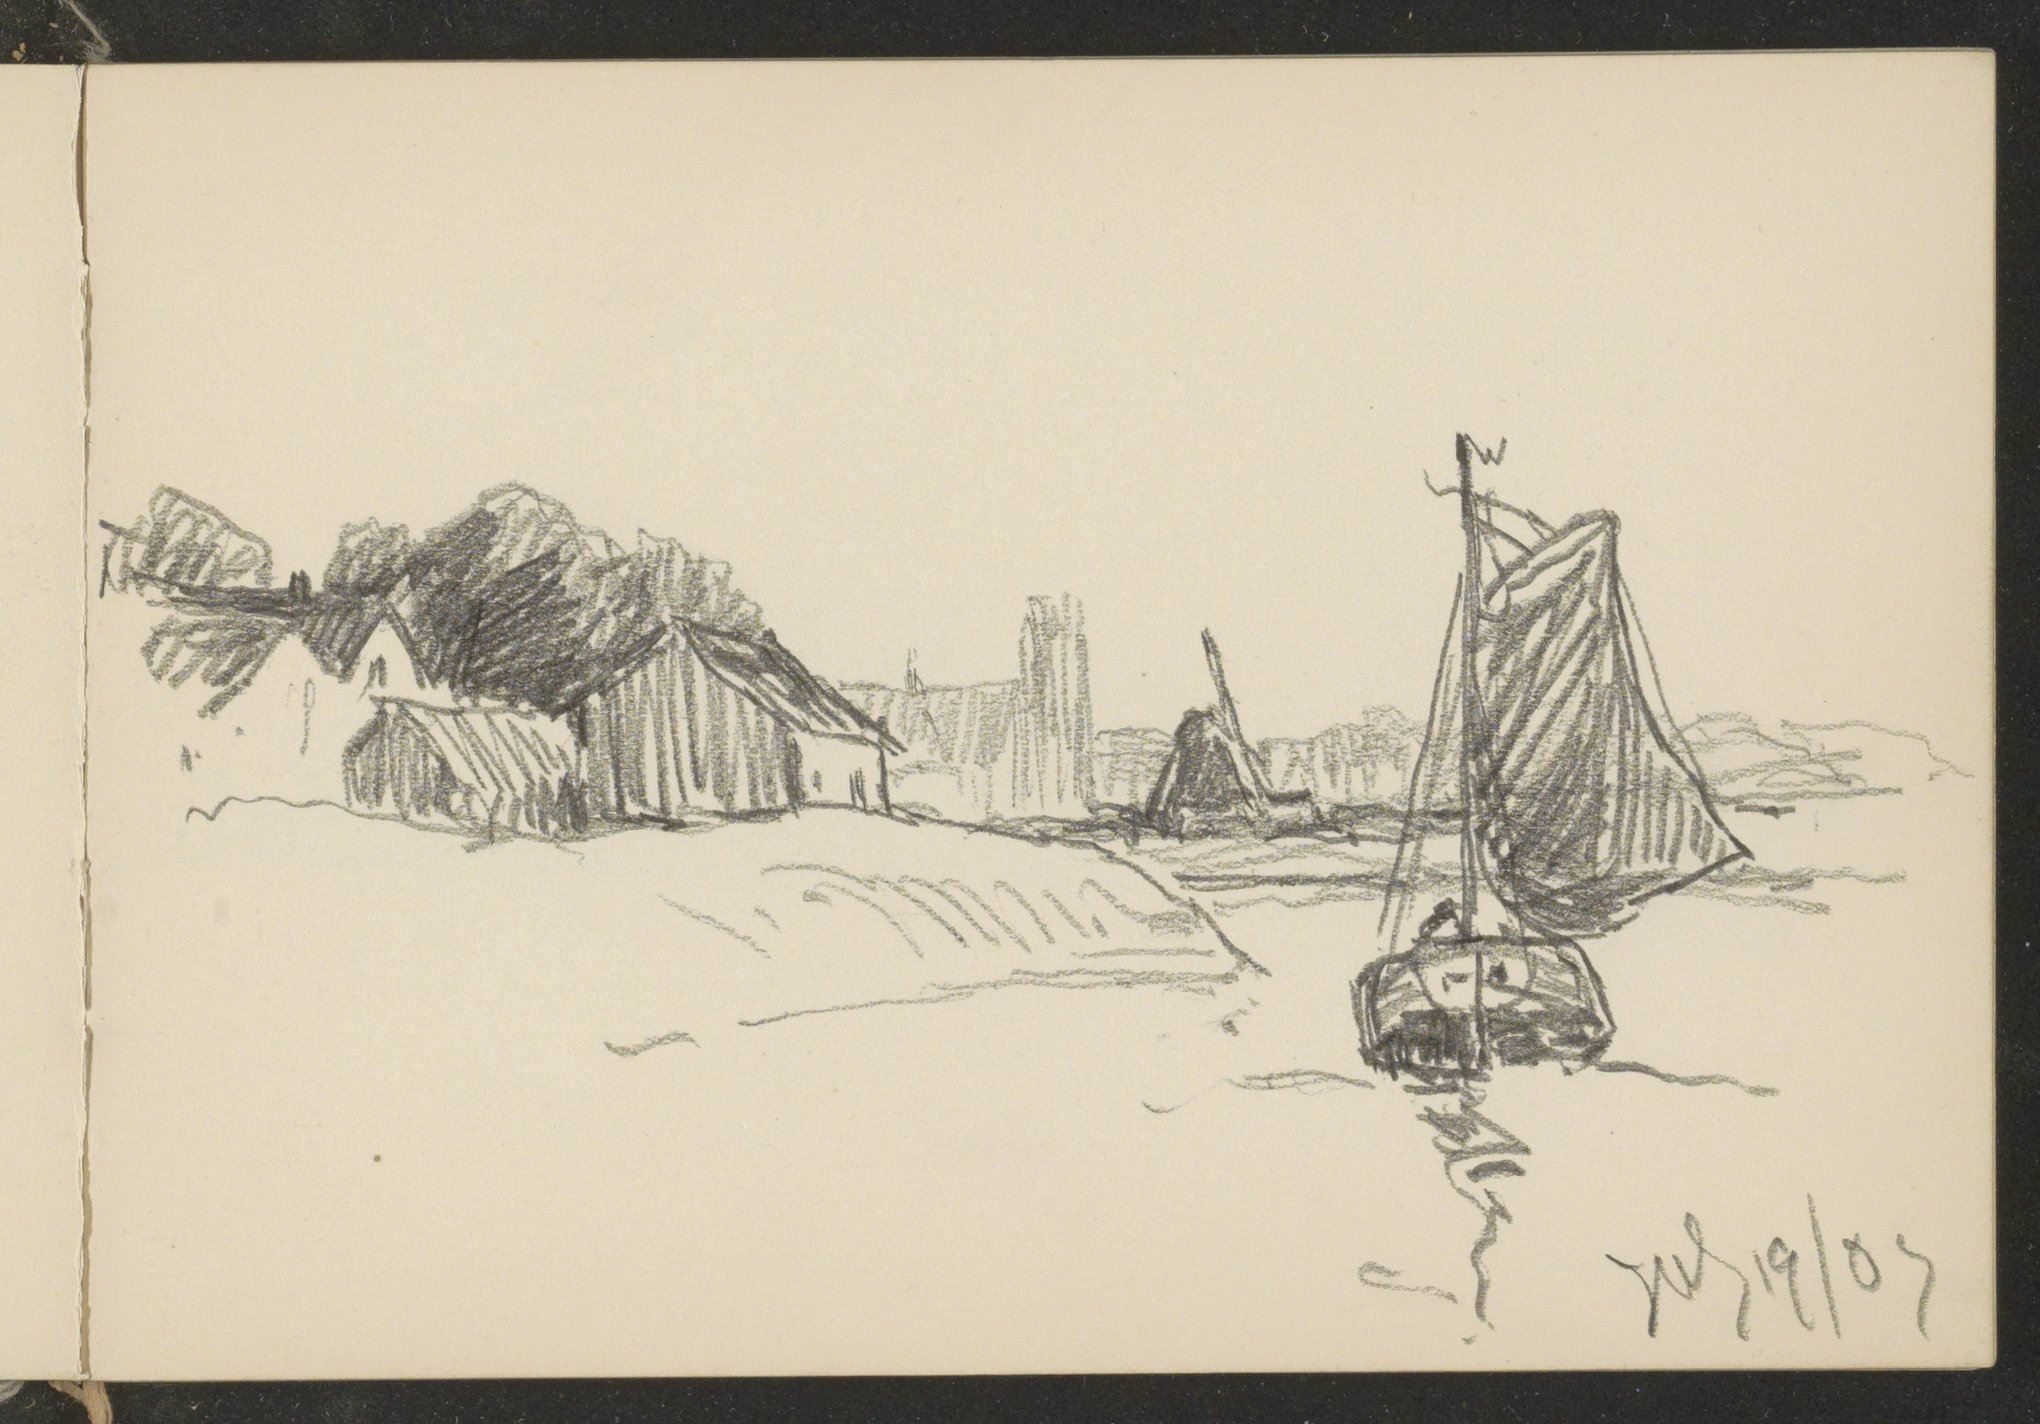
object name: sketchbook leaf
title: Gezicht op Dordrecht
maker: alexander shilling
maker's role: draughtsman, print maker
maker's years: 1859-1937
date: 1907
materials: paper, pencil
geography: dordrecht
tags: city-view, and landscape with man-made constructions, sailing-ship, sailing-boat, dordrecht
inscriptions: date: ‘July 19/07’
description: Op de voorgrond een zeilboot op het water. Blad 3 recto uit een schetsboek met 24 bladen.